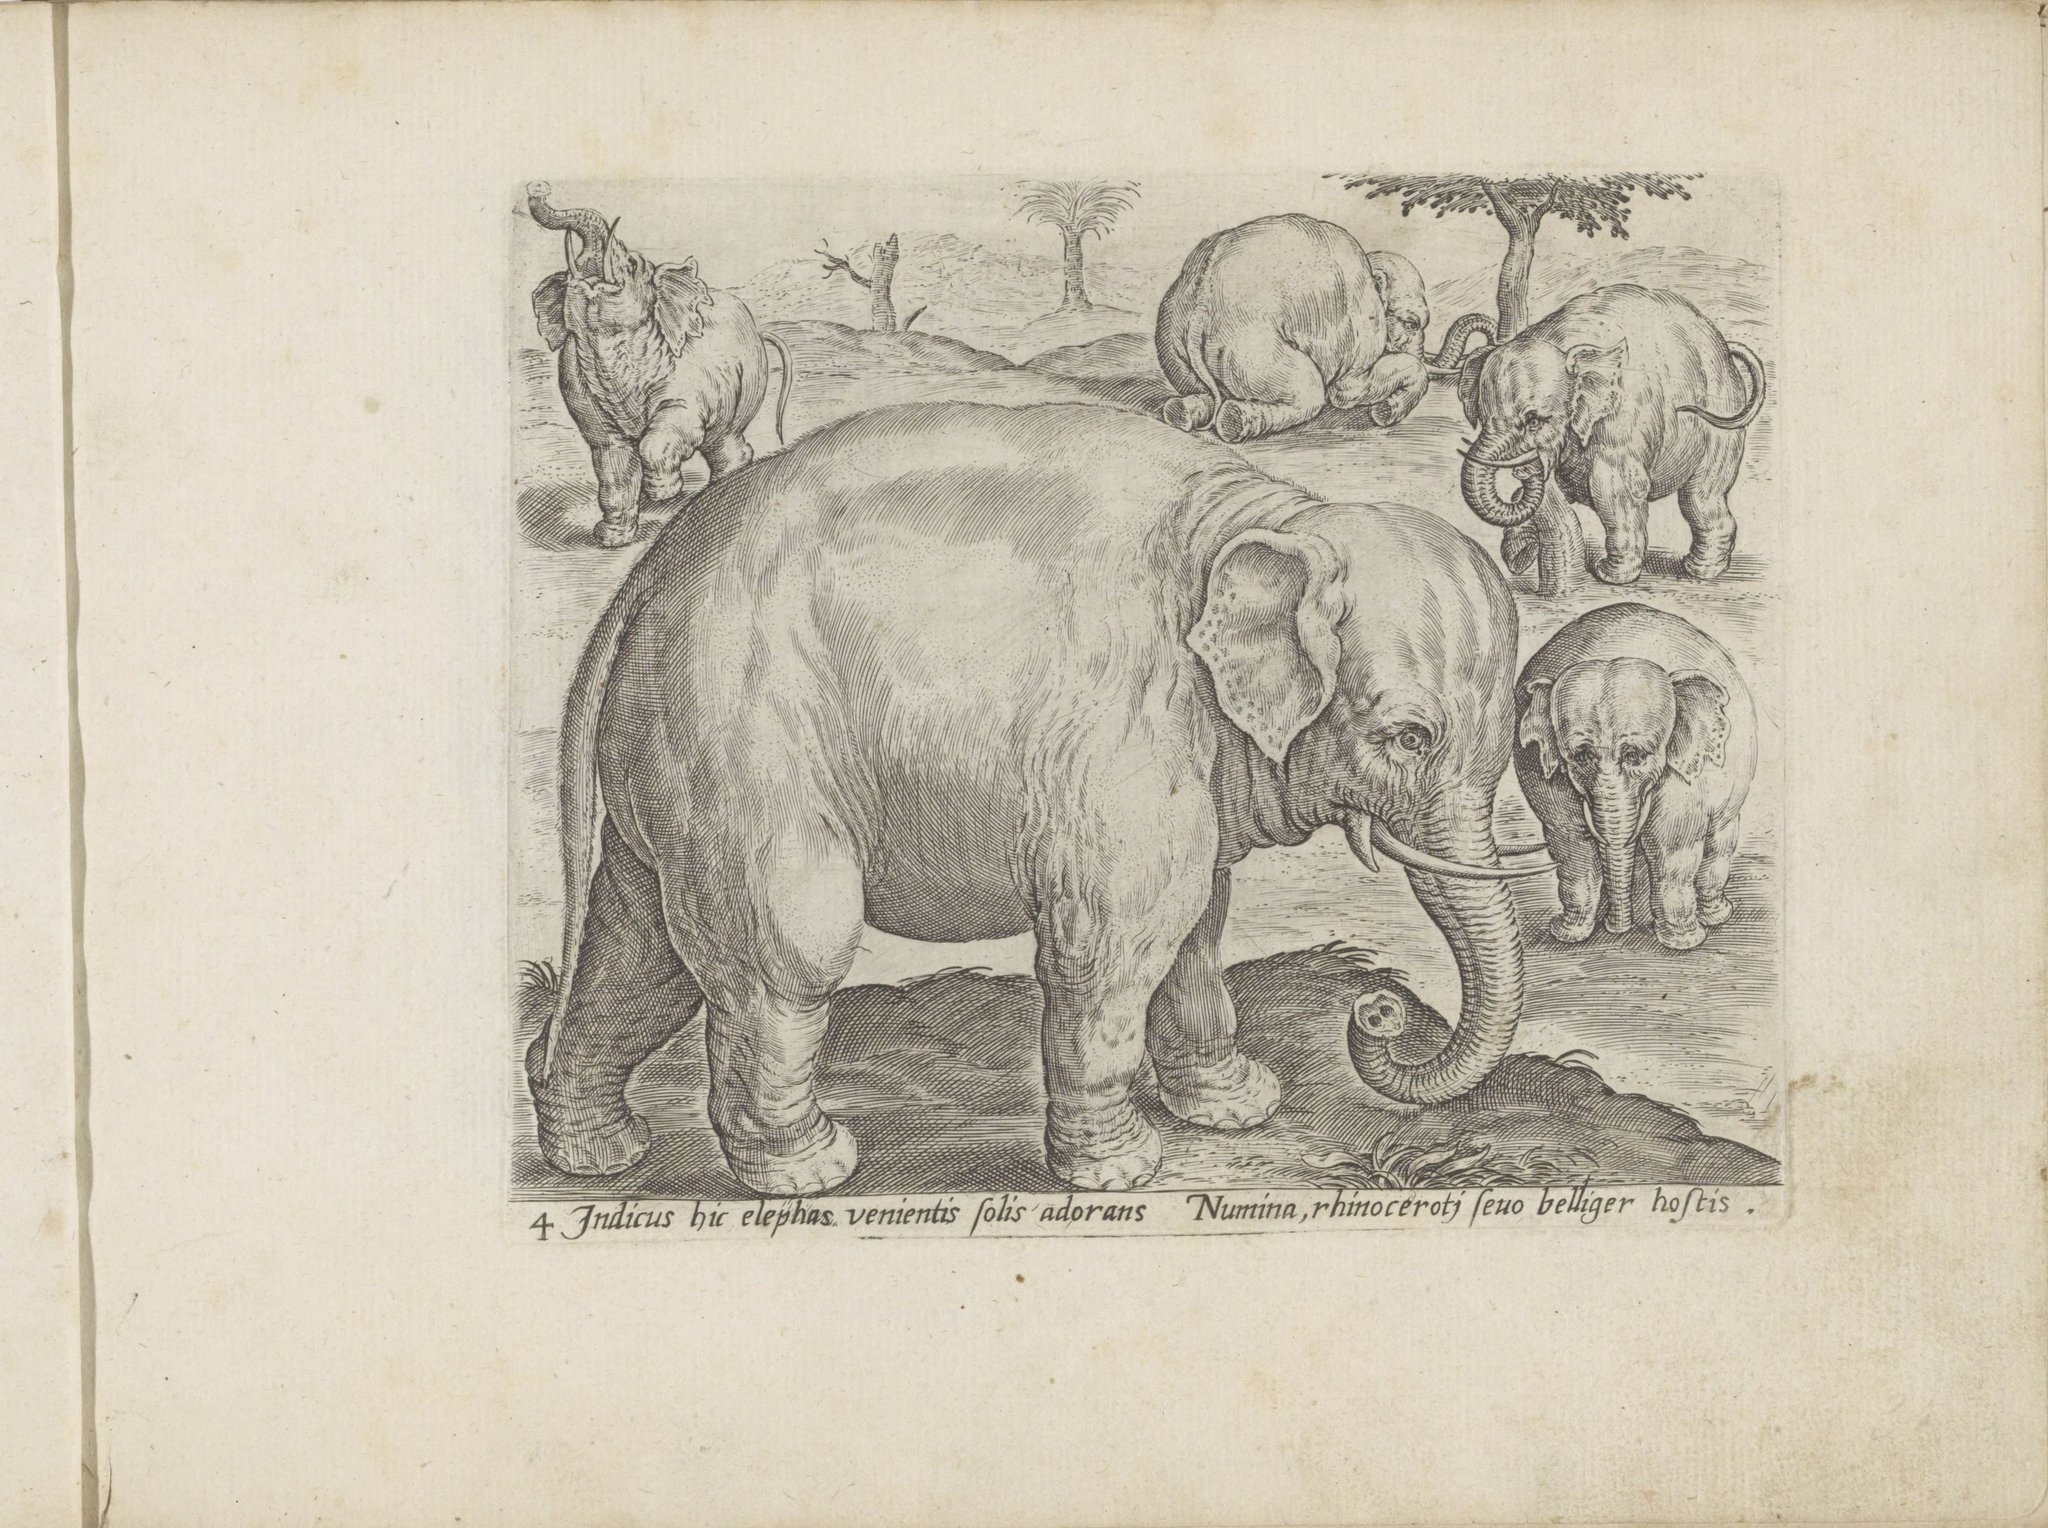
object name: album leaf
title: Dieren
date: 1581-1600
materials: paper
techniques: engraving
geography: amsterdam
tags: trunked animals: elephant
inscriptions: inscription: ‘4: Indicus hic elephas venientis folis adorans. Numina, rhinoceroti sevo belliger hostis.’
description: Vijf olifanten. Middenvoor een olifant, staande naar rechts. Linksachter een trompetterende olifant, rechtsachter een liggende en twee staande olifanten. Onderaan in de marge een verklarende tekst in het Latijn. Prent maakt deel uit van een album.